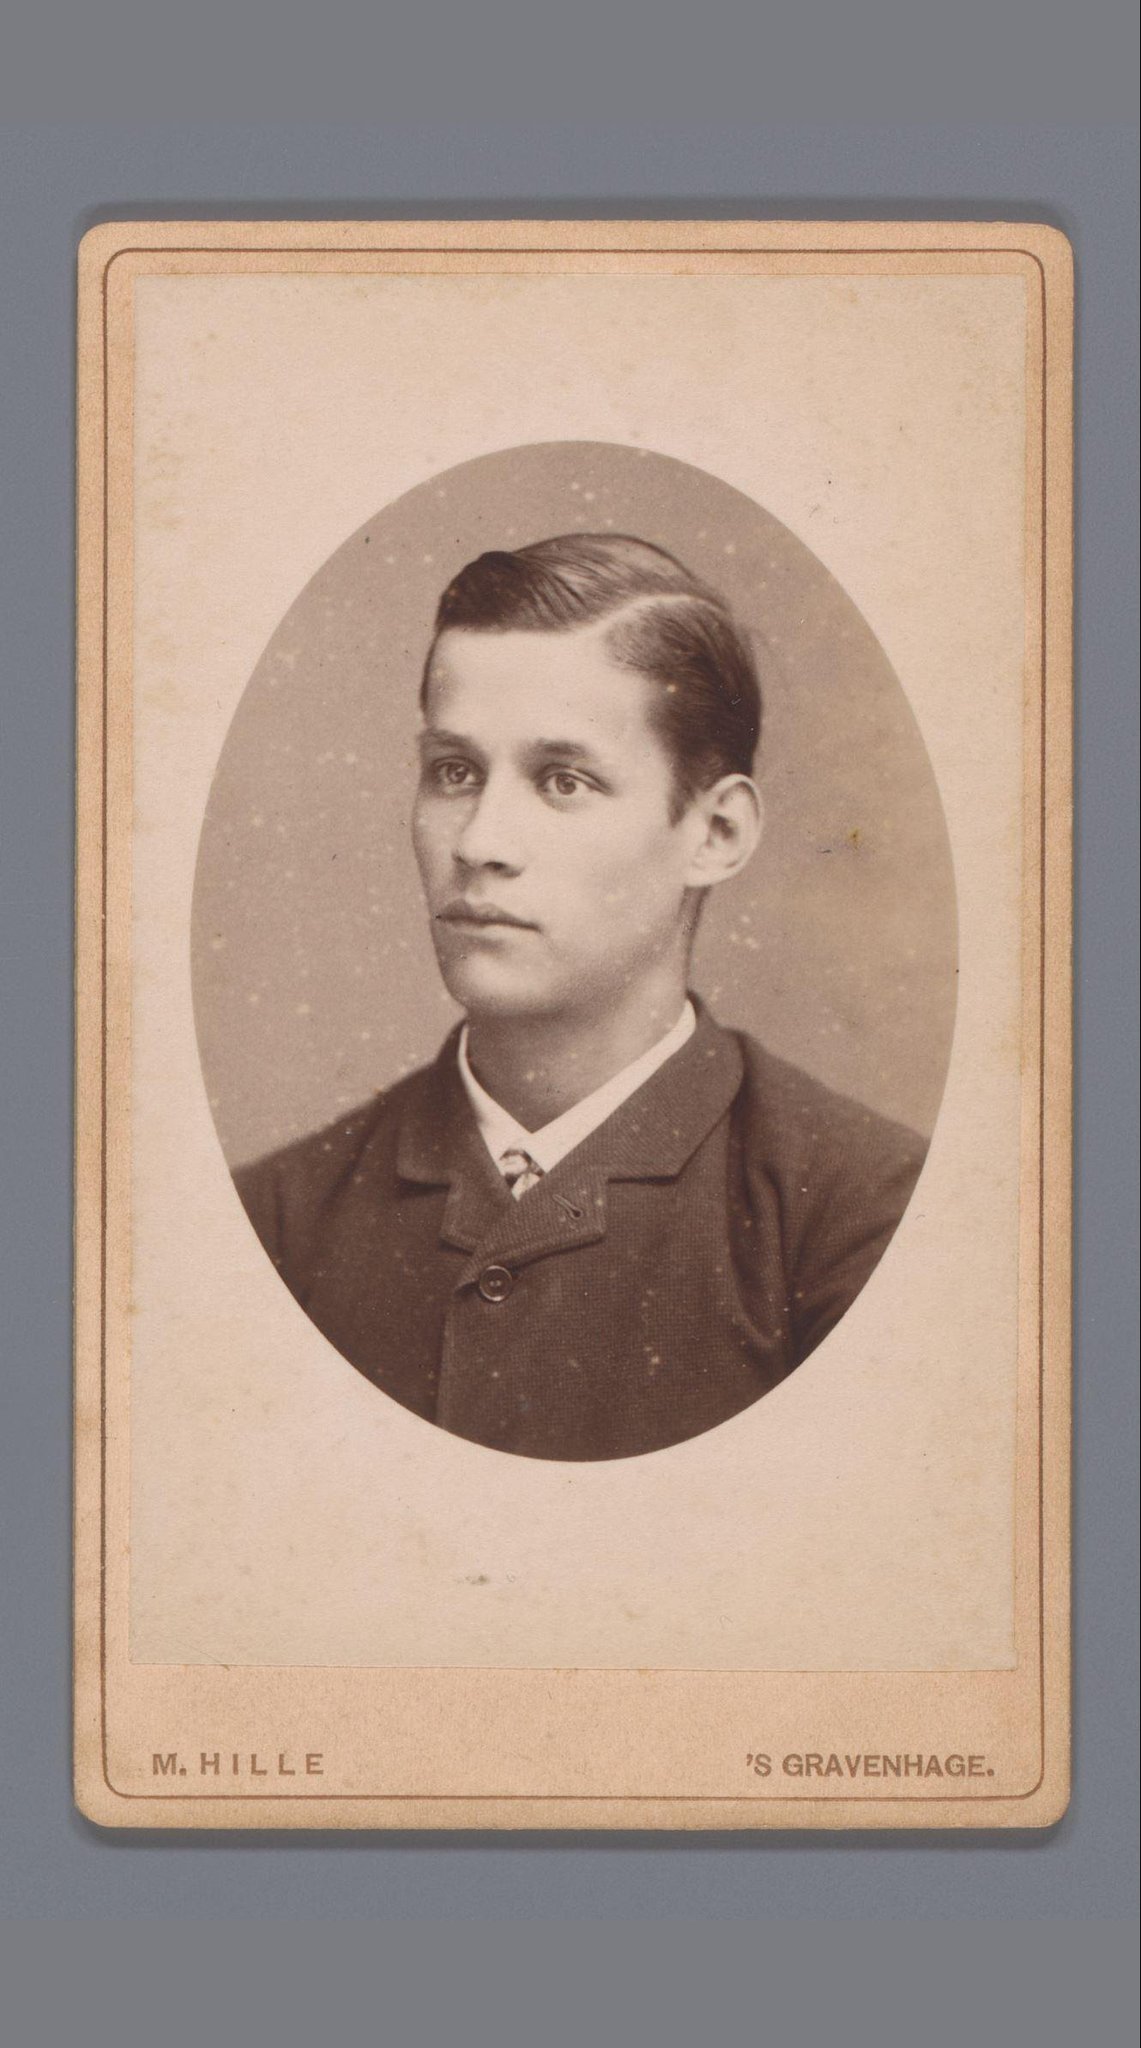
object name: photograph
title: Portret van een onbekende man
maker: maria hille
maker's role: fotograaf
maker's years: 1827-1893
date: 1884-1885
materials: cardboard, paper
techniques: albumen print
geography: the hague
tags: adult man, historical persons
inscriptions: inscription: ‘MH/ Photographie/ Instantanée/ M. HILLE/ 'S GRAVENHAGE/ 64, Veenlaan 64,/ (Hoek Elandstraat.)/ Voor nabestellingen/ worden de platen/ bewaard.’